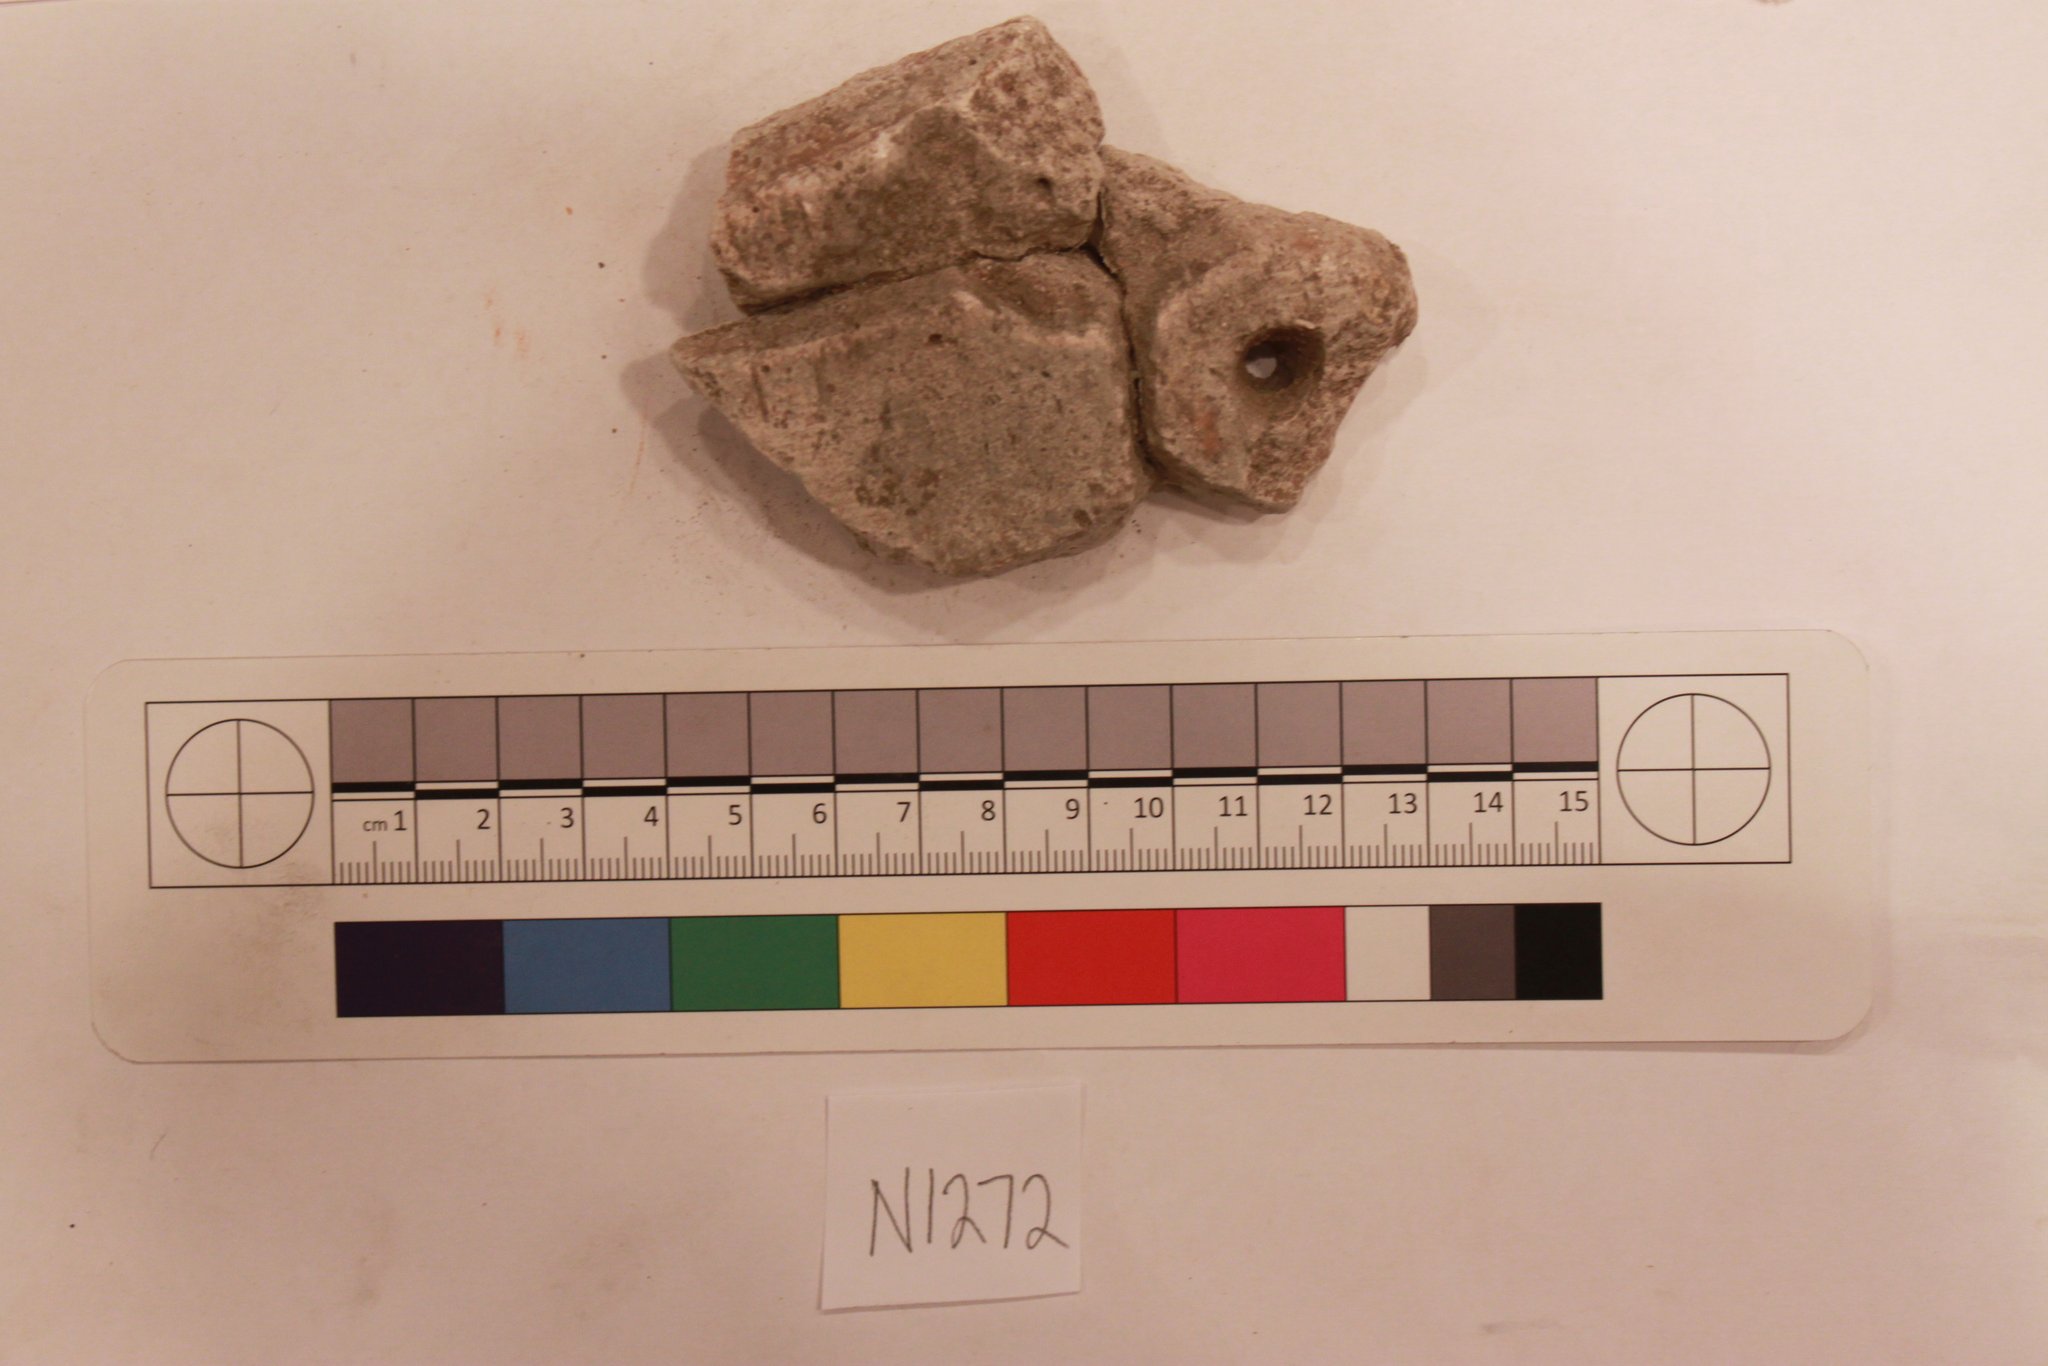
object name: fragment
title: Stucco Fragment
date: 701-1200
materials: plaster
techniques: carving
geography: iran